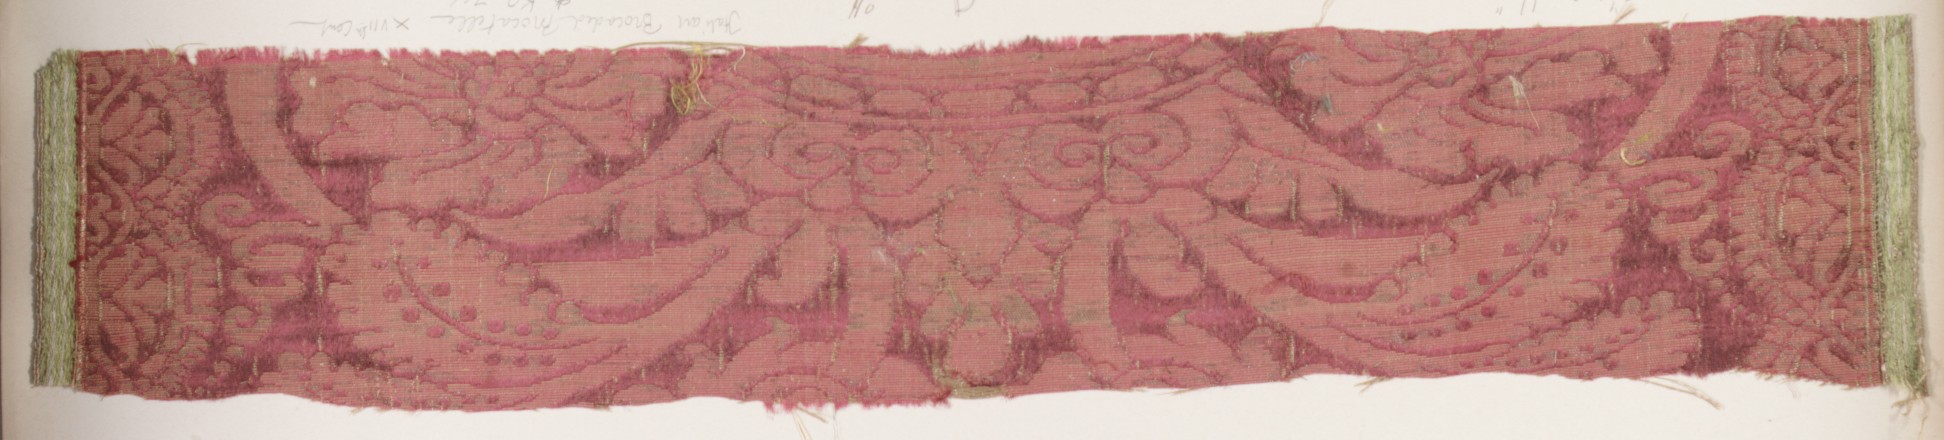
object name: fragment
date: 1601-1700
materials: metal thread, silk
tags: flowers,leaves